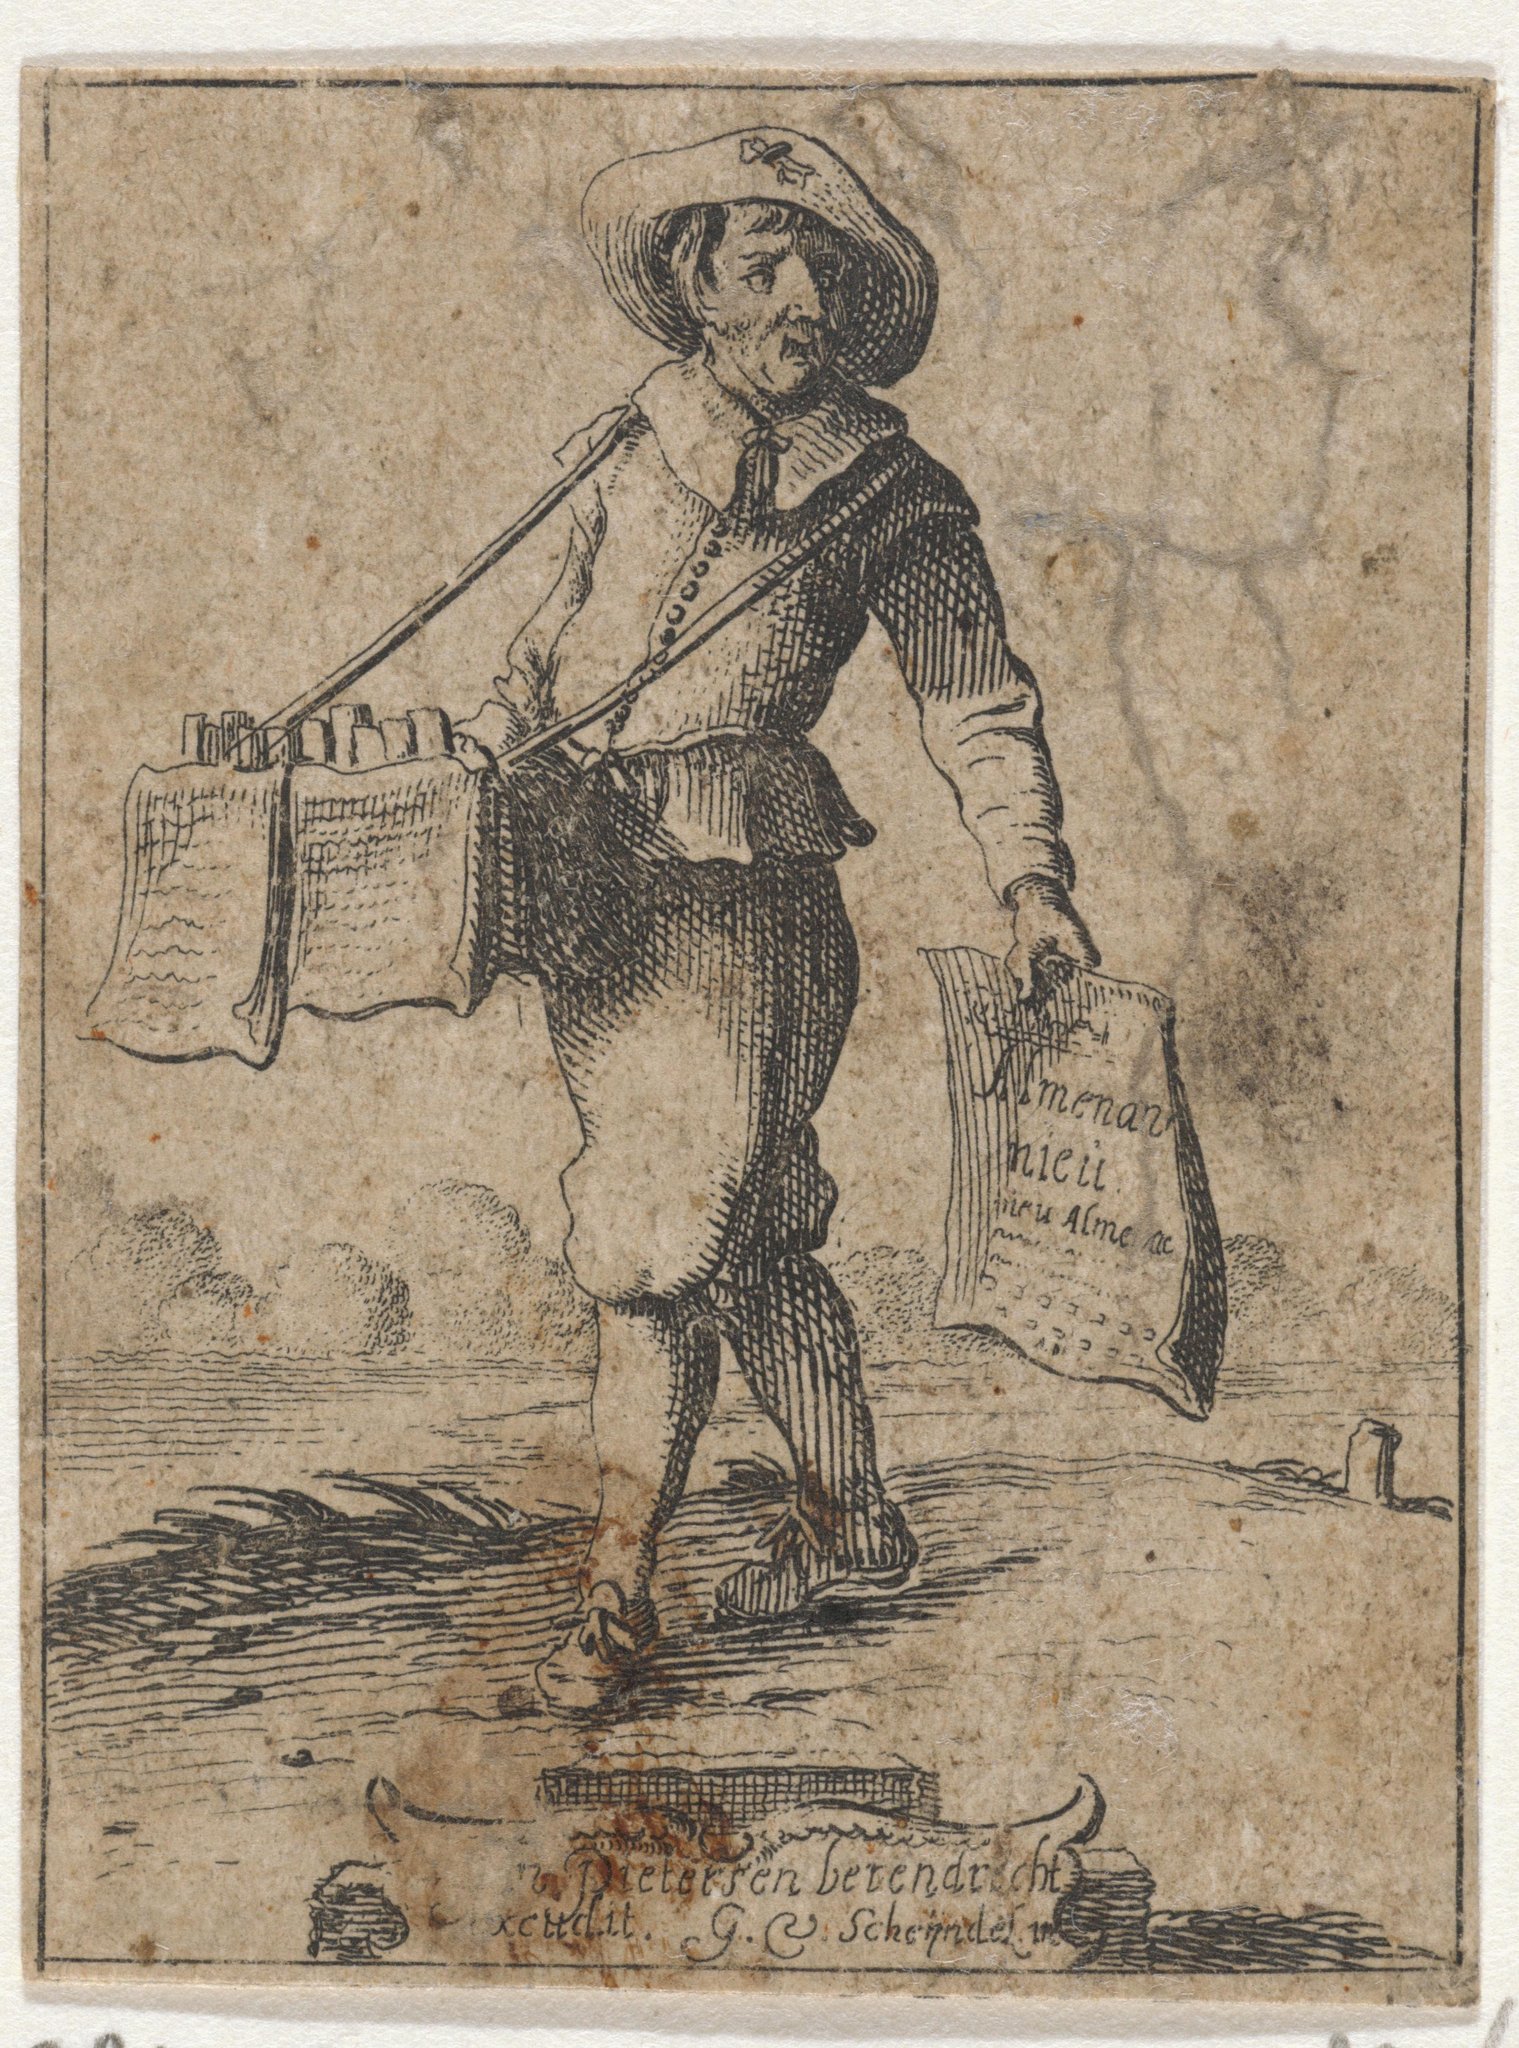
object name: titelprent, frontispice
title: Marskramer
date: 1618-1638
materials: paper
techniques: etching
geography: haarlem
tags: pedlar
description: Een venter met om de hals een bak met koopwaar kondigt zijn handelswaar aan. In de hand heeft hij een bundel papier met daarop de tekst: "Almen nieu nieu Almenac." Titelprent van een serie van 32 prenten met genretaferelen.